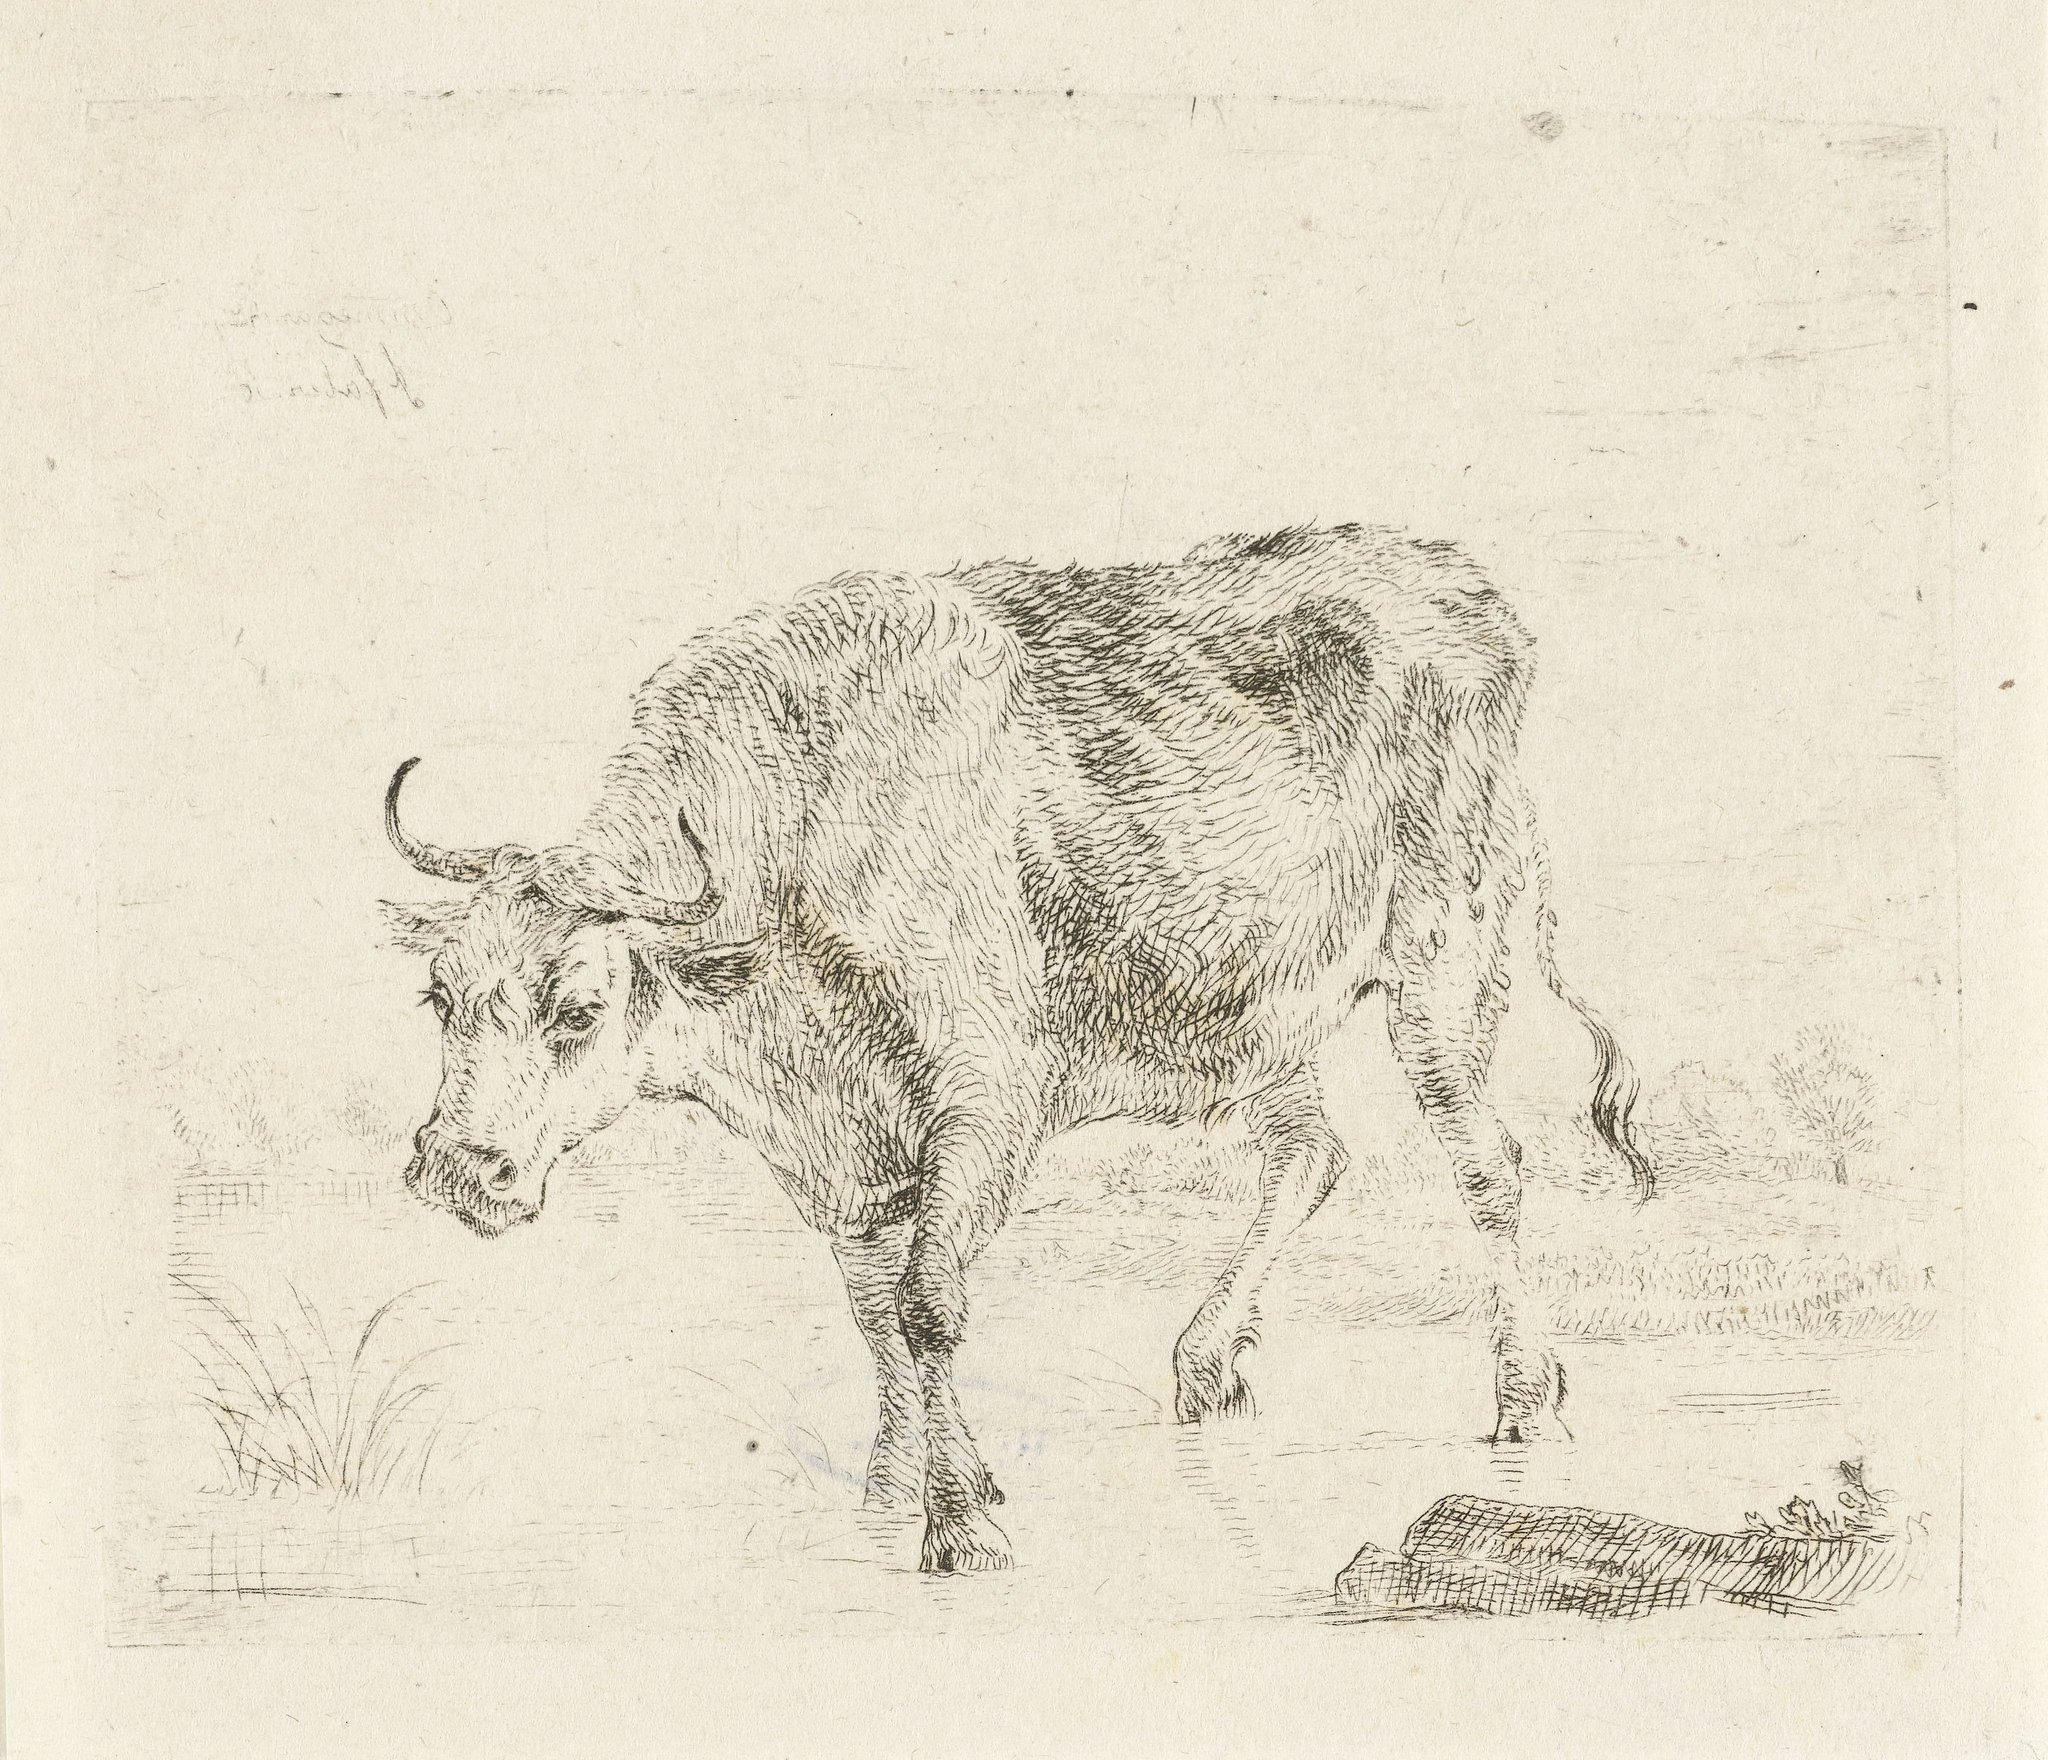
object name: print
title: Os in ondiep water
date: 1805-1806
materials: paper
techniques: etching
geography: antwerp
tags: ox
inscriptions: collector's mark: Lugt 2228